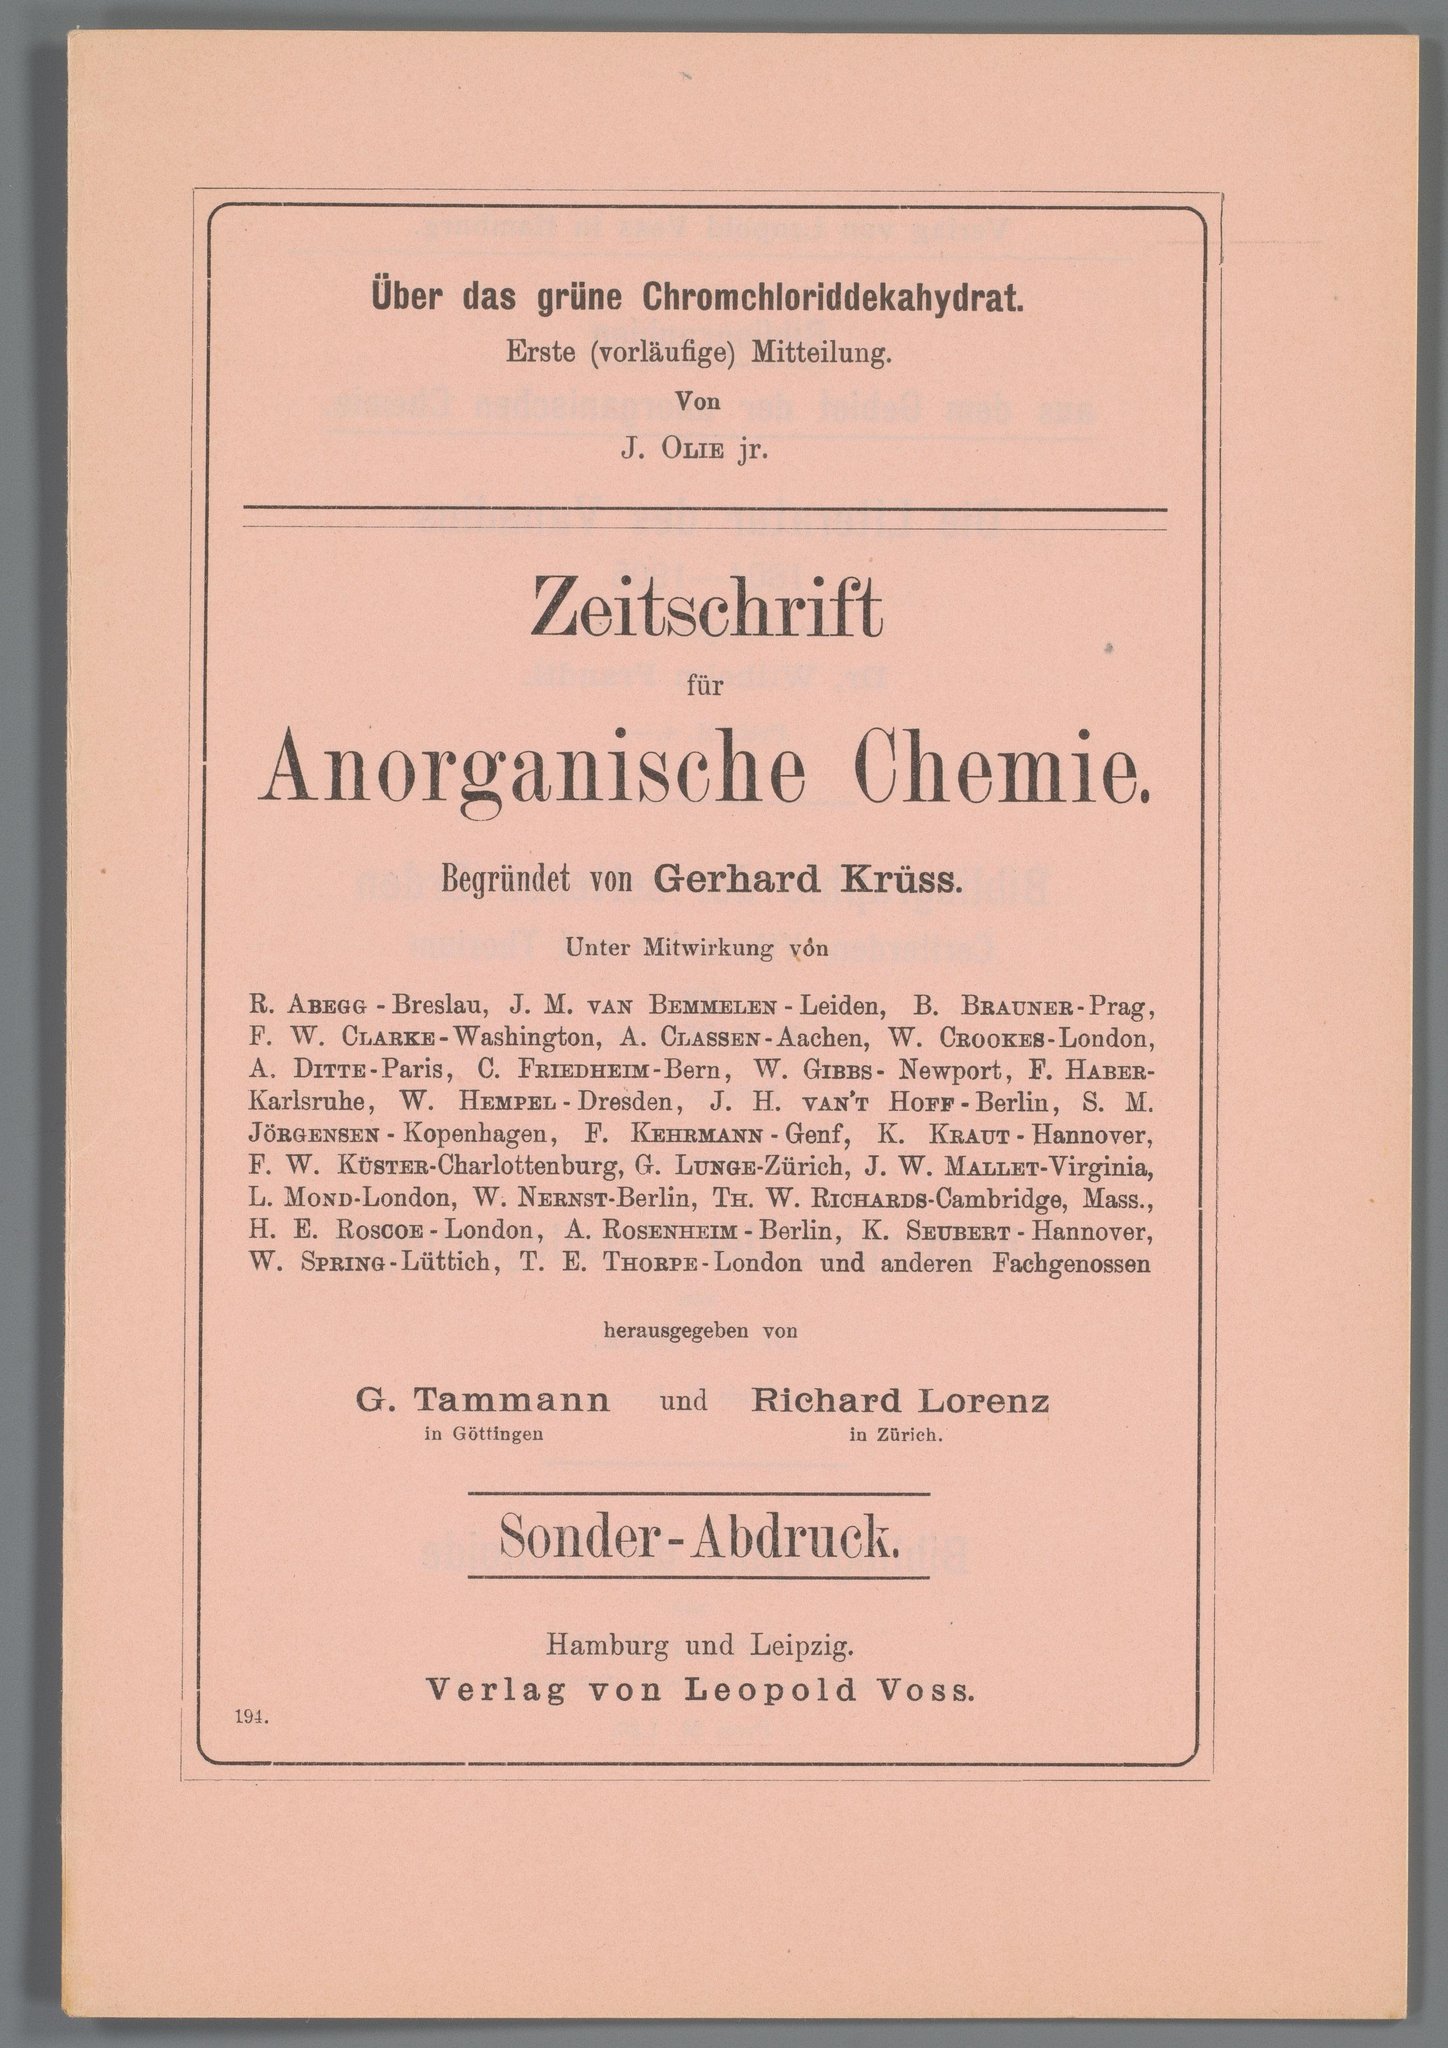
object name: offprint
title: Zeitschrift für Anorganische Chemie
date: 1902-1907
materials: paper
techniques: letterpress printing, printing block, engraving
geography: amsterdam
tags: printed matter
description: Overdruk uit het 'Zeitschrift für Anorganische Chemie'.